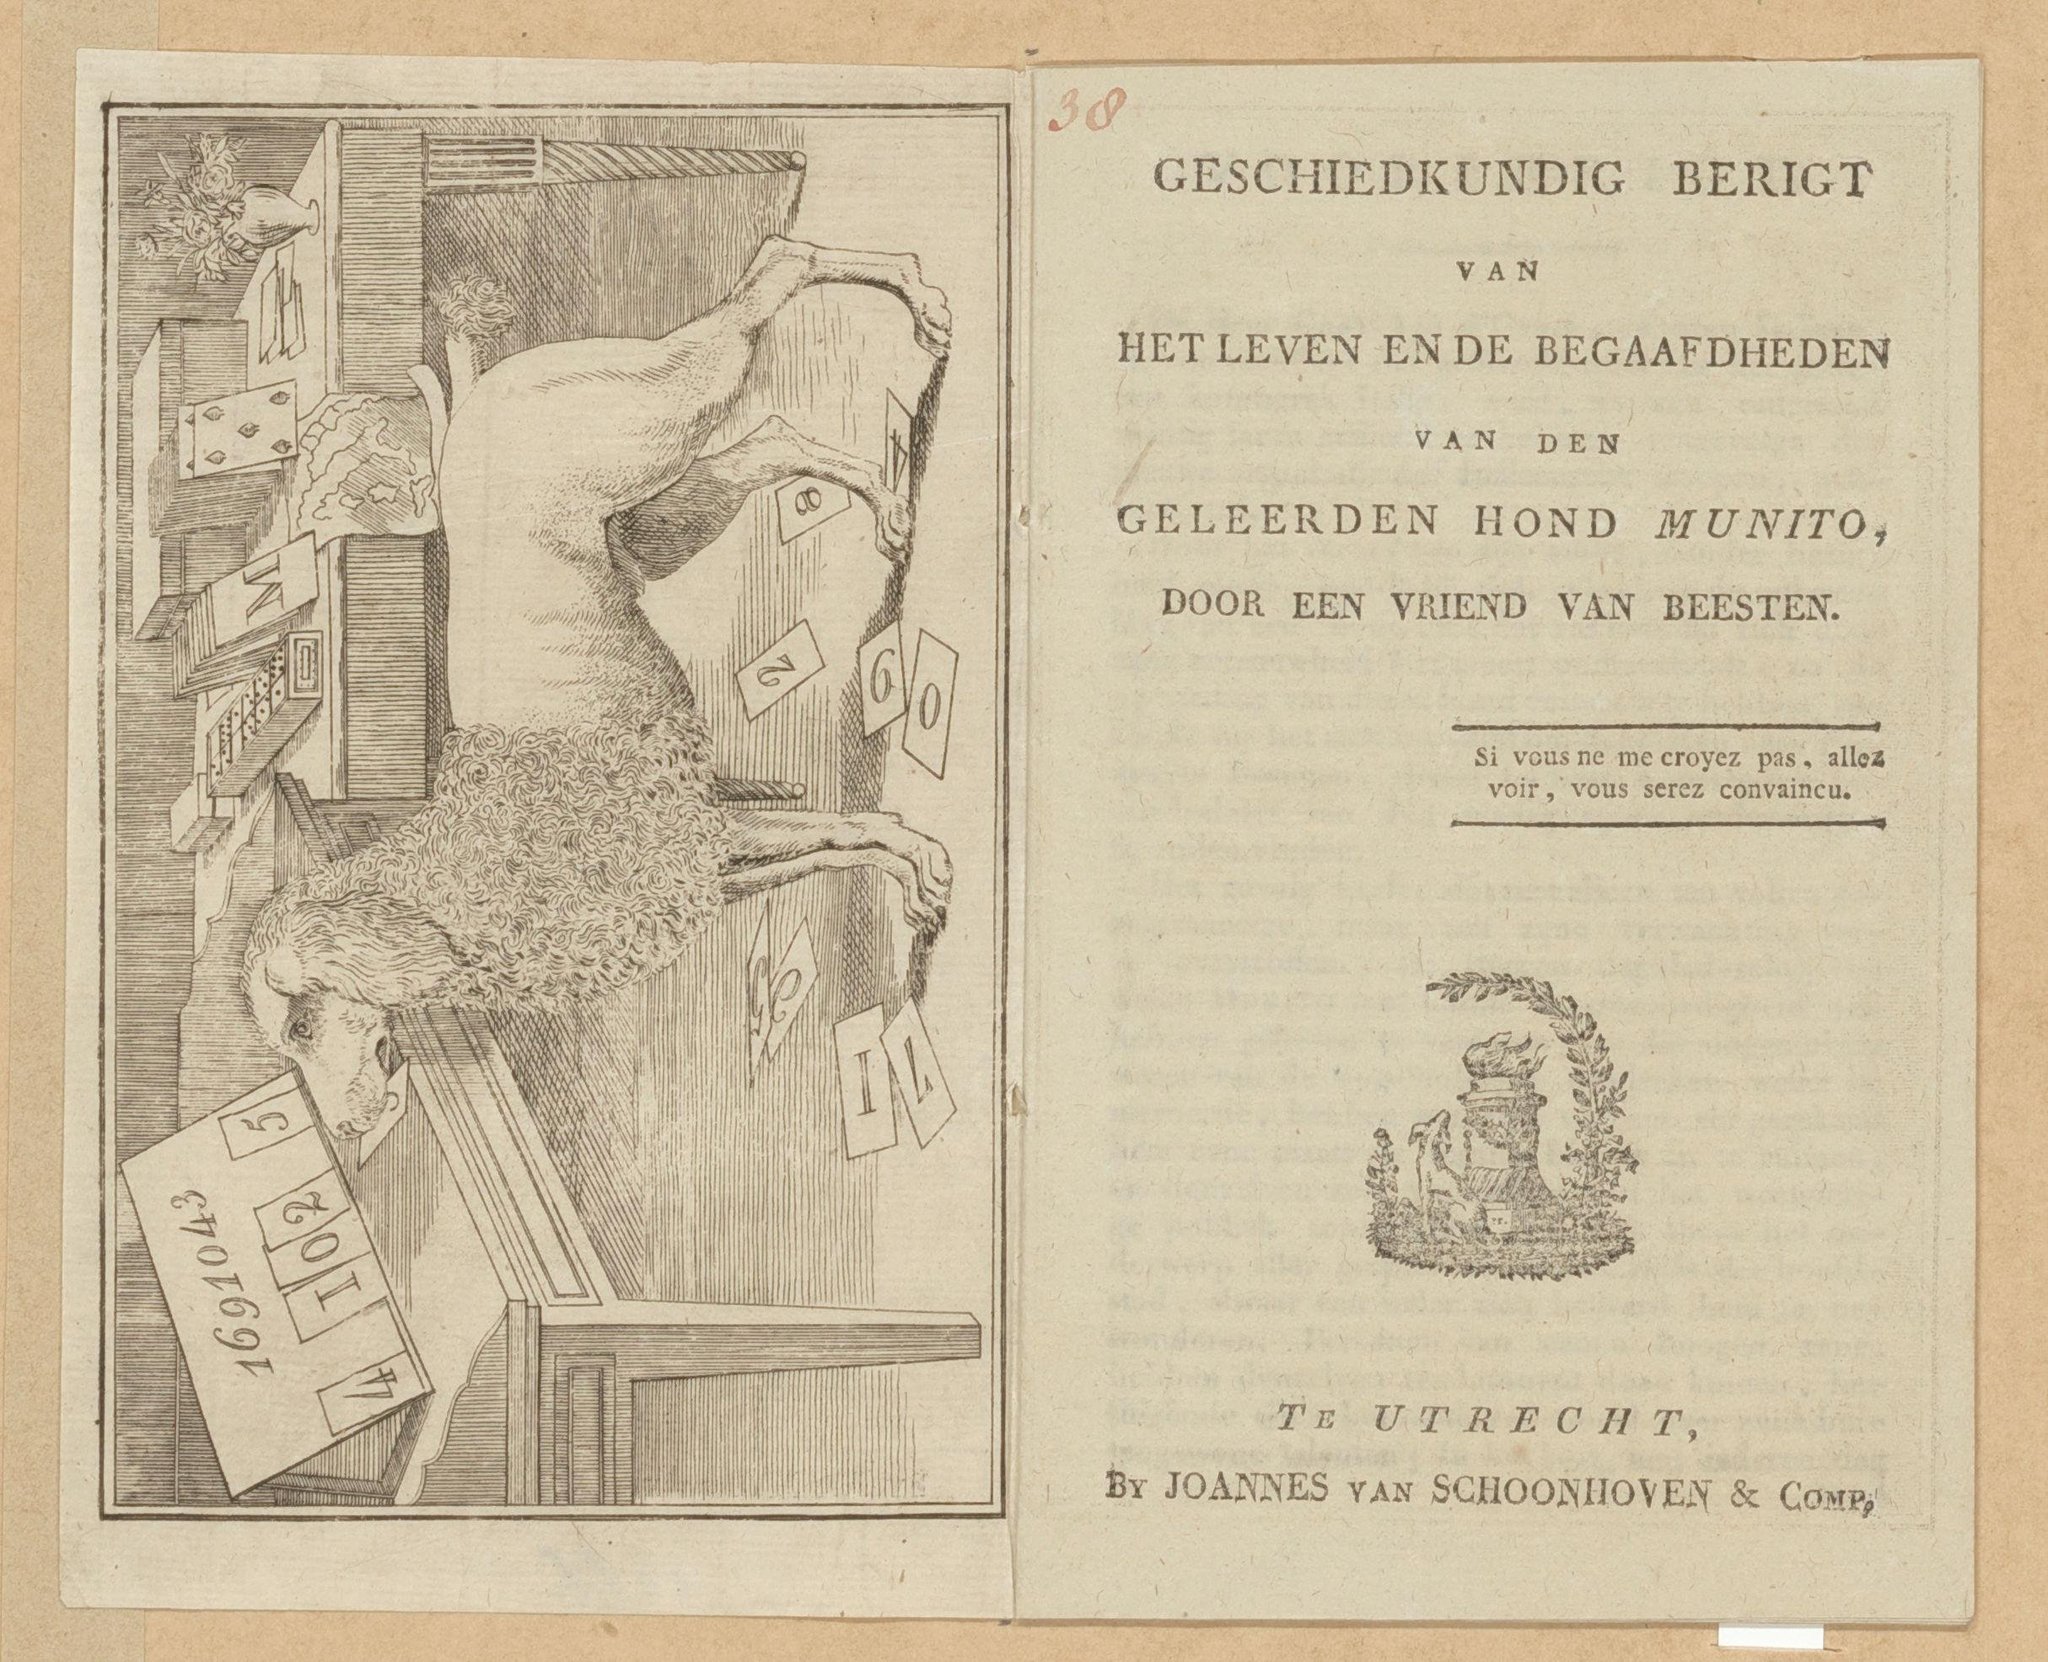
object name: text sheet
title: Geschiedkundig berigt van het leven en de begaafdheden van den Geleerden Hond Munito, door een vriend van beesten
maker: Anonymous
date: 1820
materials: paper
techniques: engraving, letterpress printing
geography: utrecht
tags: dog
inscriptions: collector's mark: Lugt 1641, stamp, stamp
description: Onderwerpsrubrieken binnen de Atlas Zeden en Gewoonten: Zeden en Gewoonten in Engeren Zin. Volksleven. Volksfeesten. Circusmenschen, dierentemmers, acrobaten, goochelaars, en dergelijken.